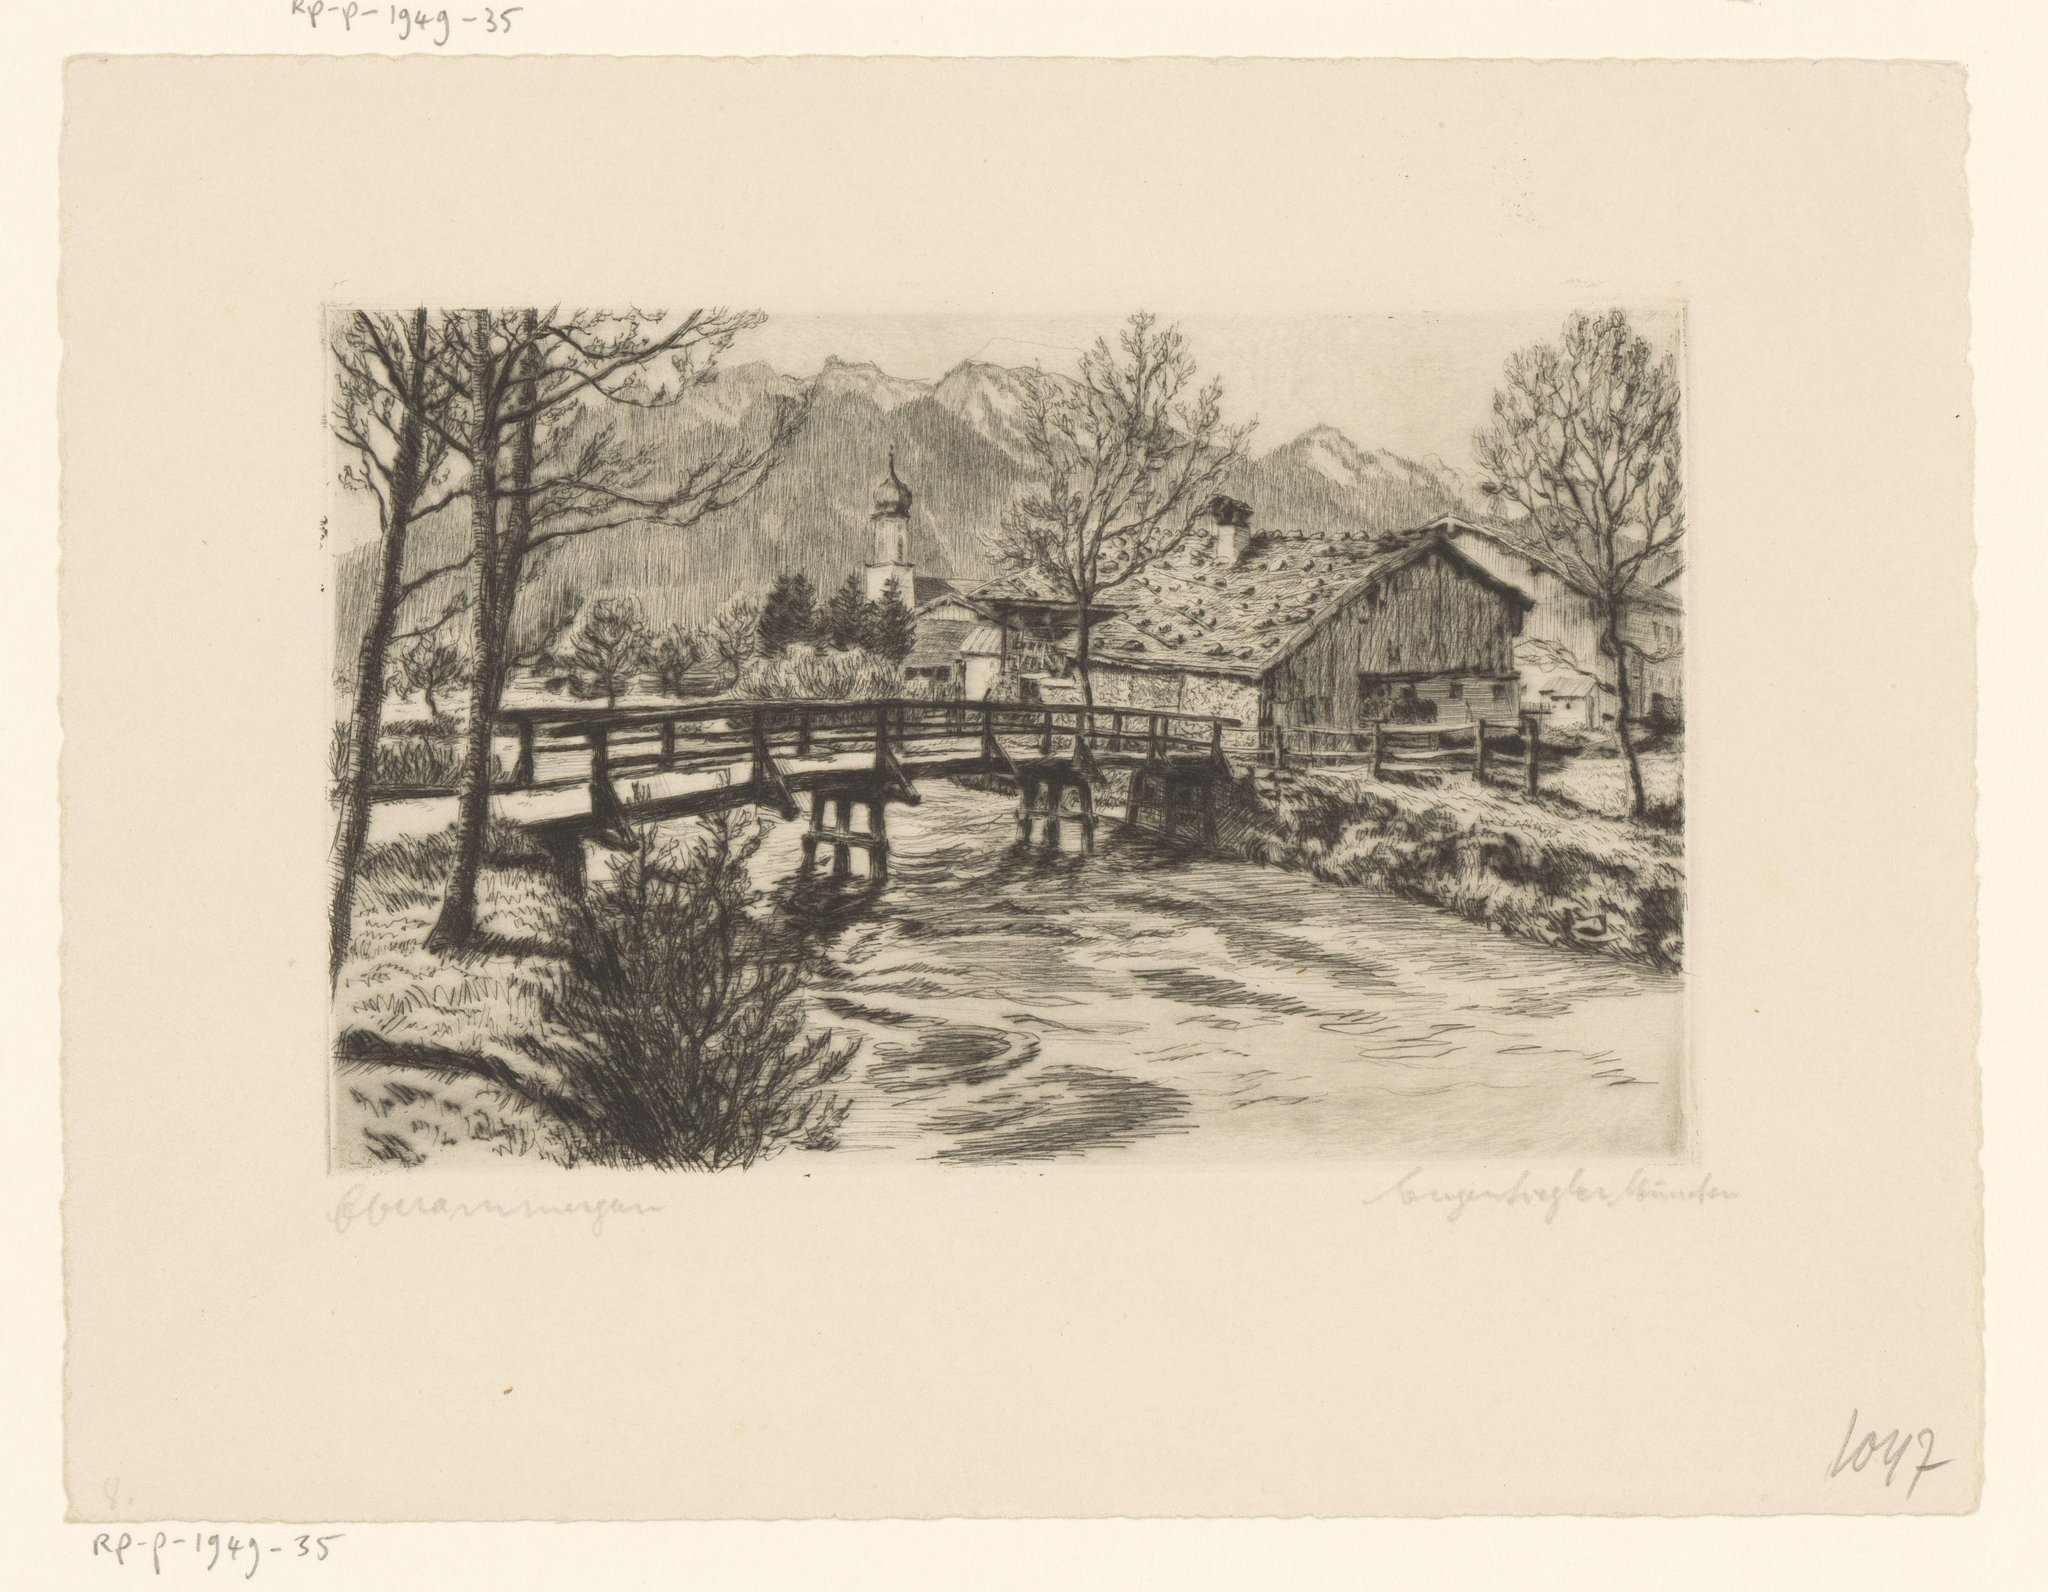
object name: print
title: Gezicht op Oberammergau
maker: eugen siegler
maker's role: print maker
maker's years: 1894-1952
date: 1904-1949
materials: paper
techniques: drypoint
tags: city-view, and landscape with man-made constructions, oberammergau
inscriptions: name: ‘Eugen Siegler’, collector's mark: Lugt 2228, title: ‘Oberammergau’